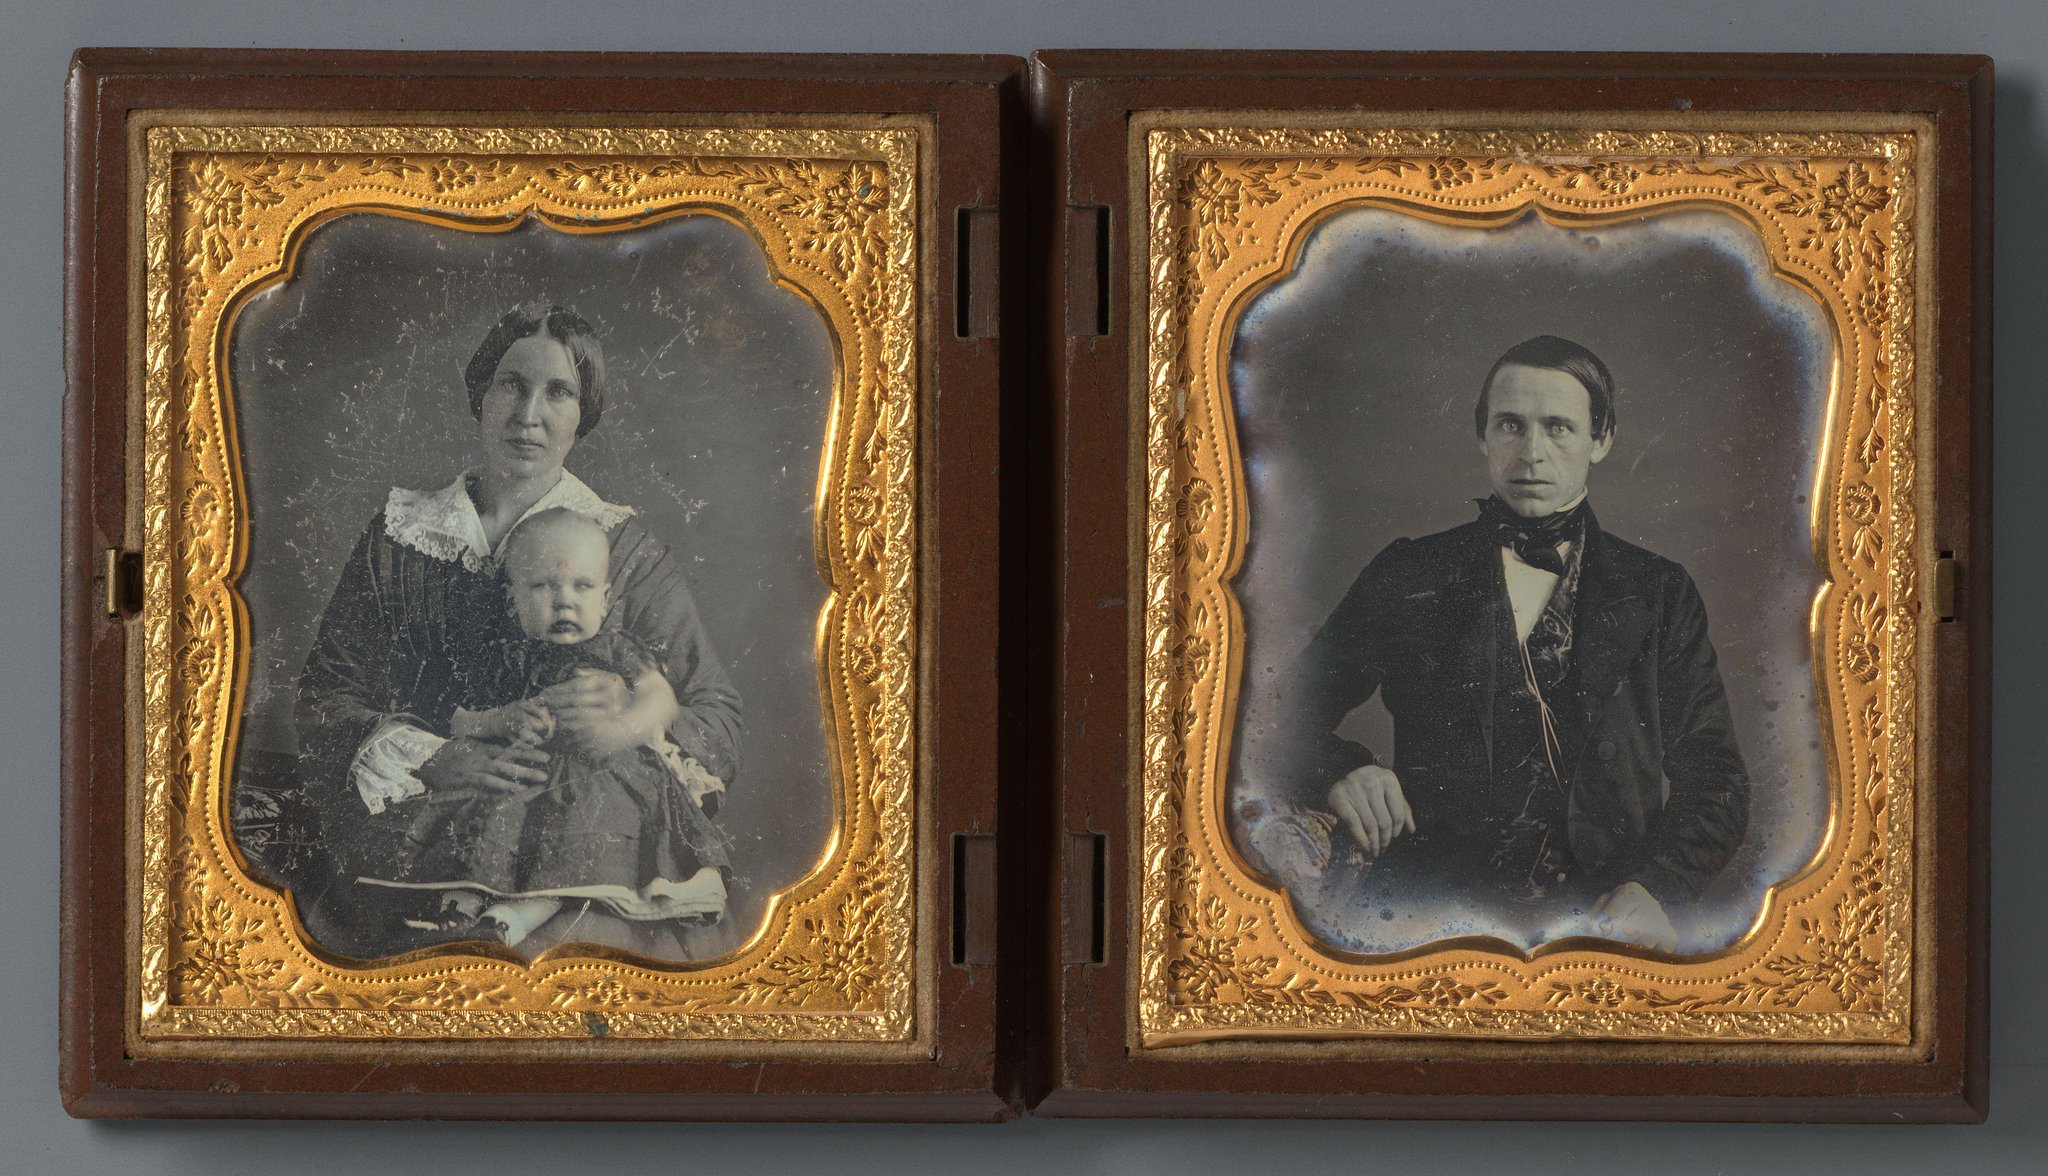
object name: photograph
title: Portret van een onbekende man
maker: Anonymous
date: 1858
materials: copper, glass, plastic, velvet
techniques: daguerreotype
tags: adult man, historical persons